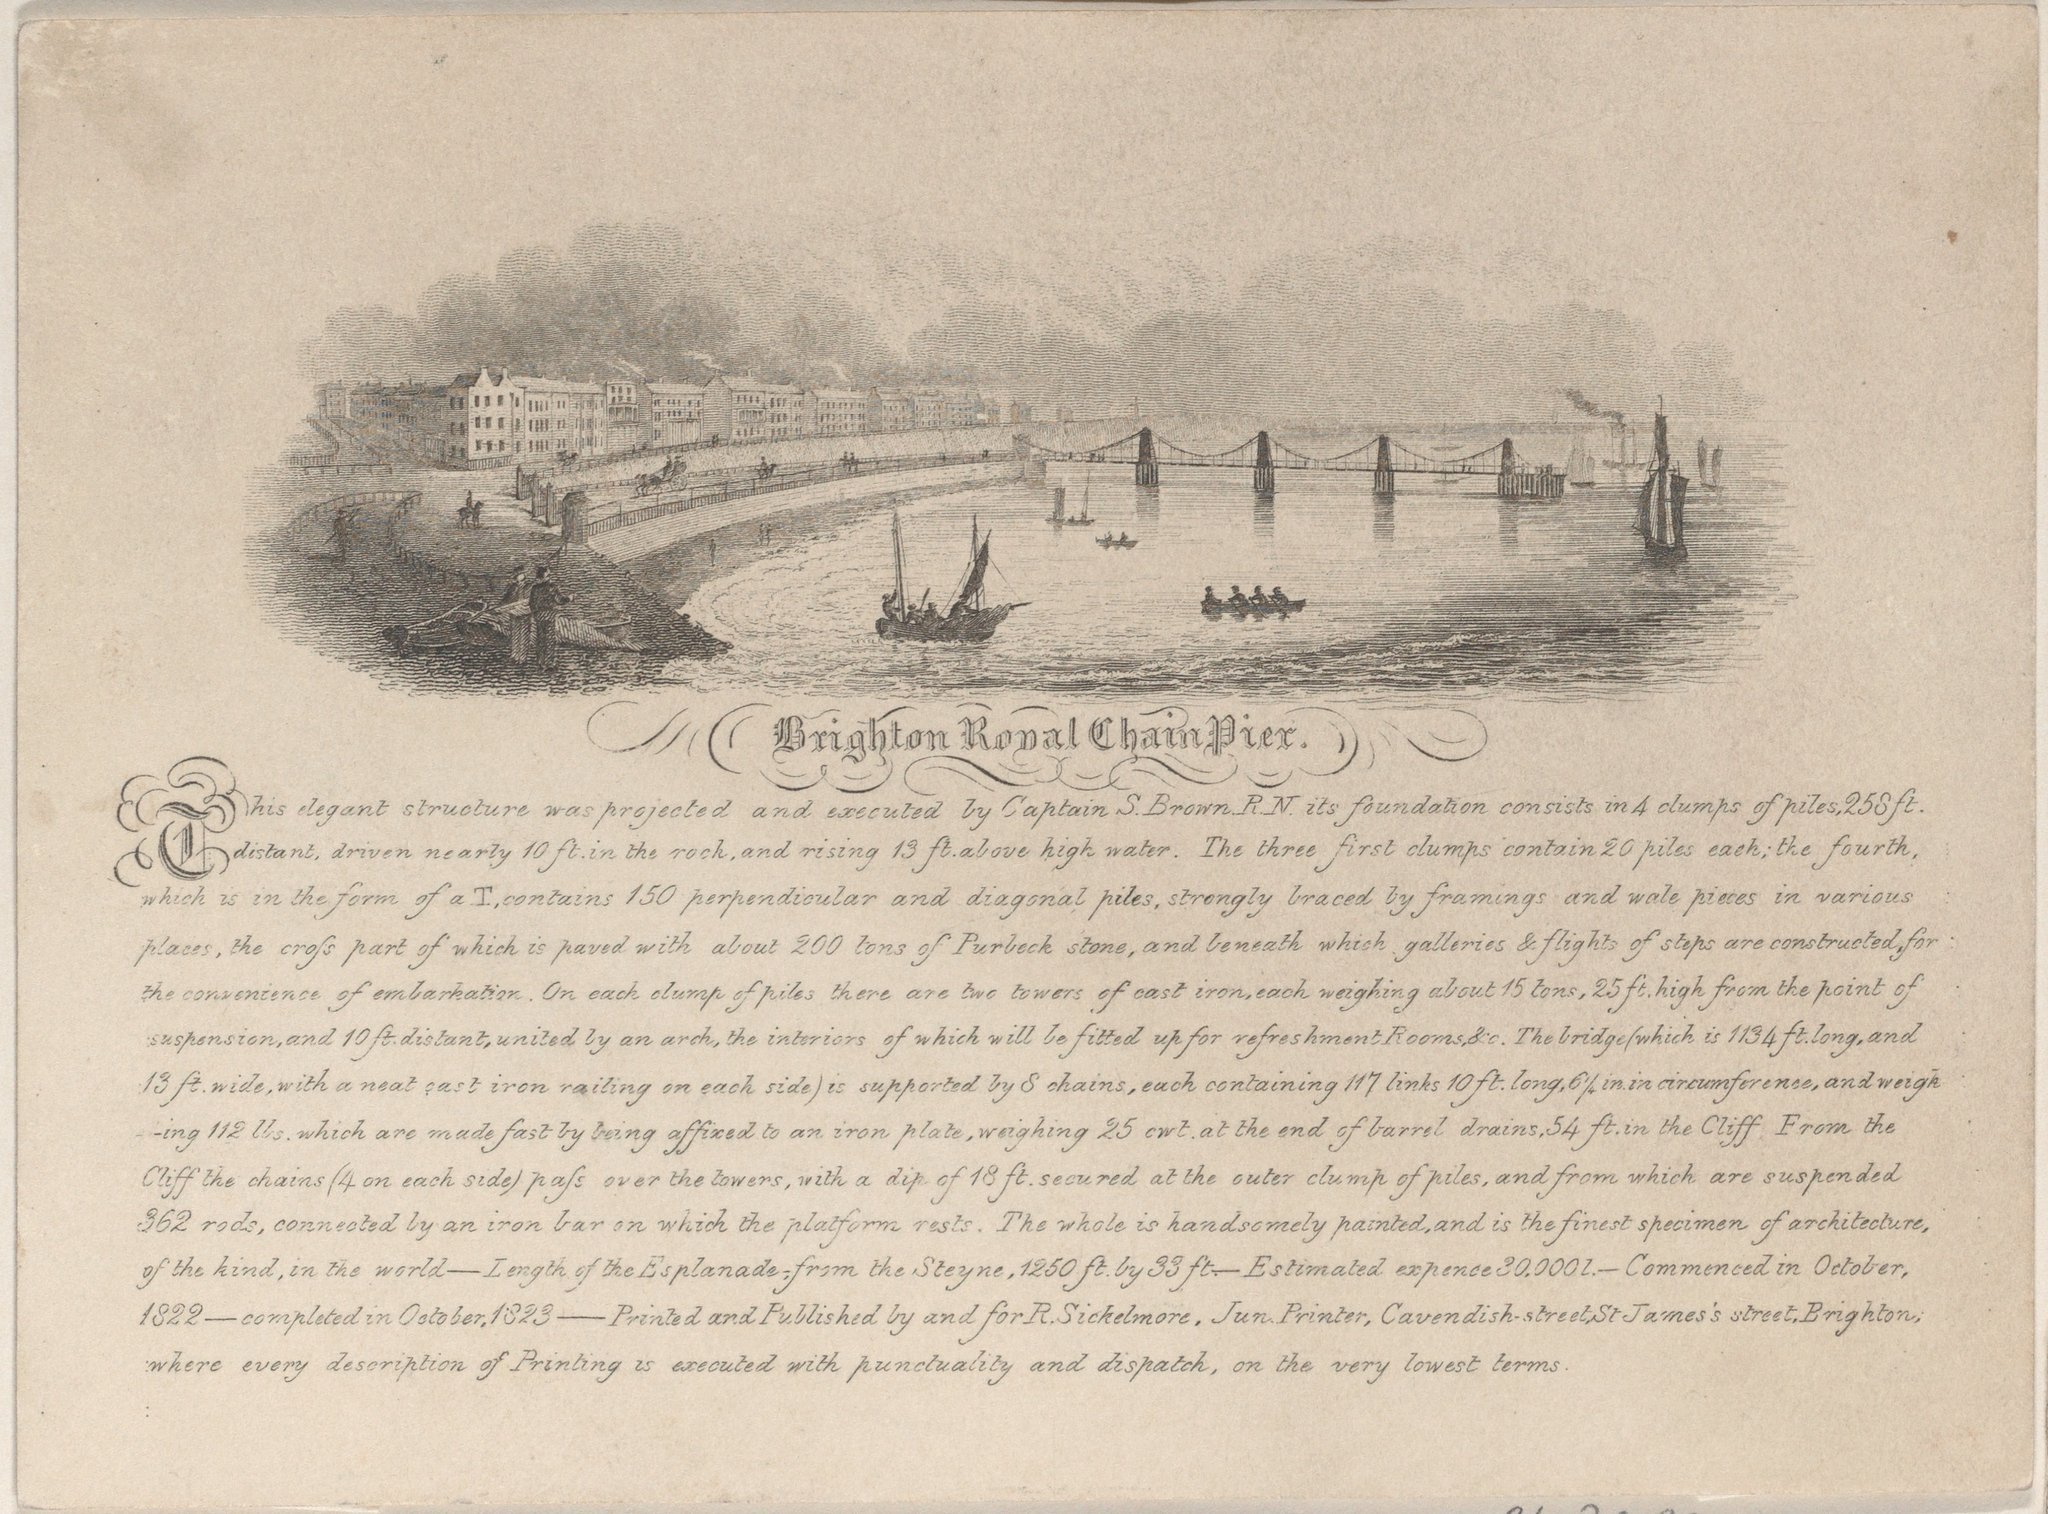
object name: print, trade card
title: Trade Card for R. Sickelmore, Printer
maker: anonymous, british, 19th century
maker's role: artist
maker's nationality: british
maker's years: 1800-1900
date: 1801-1900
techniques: engraving